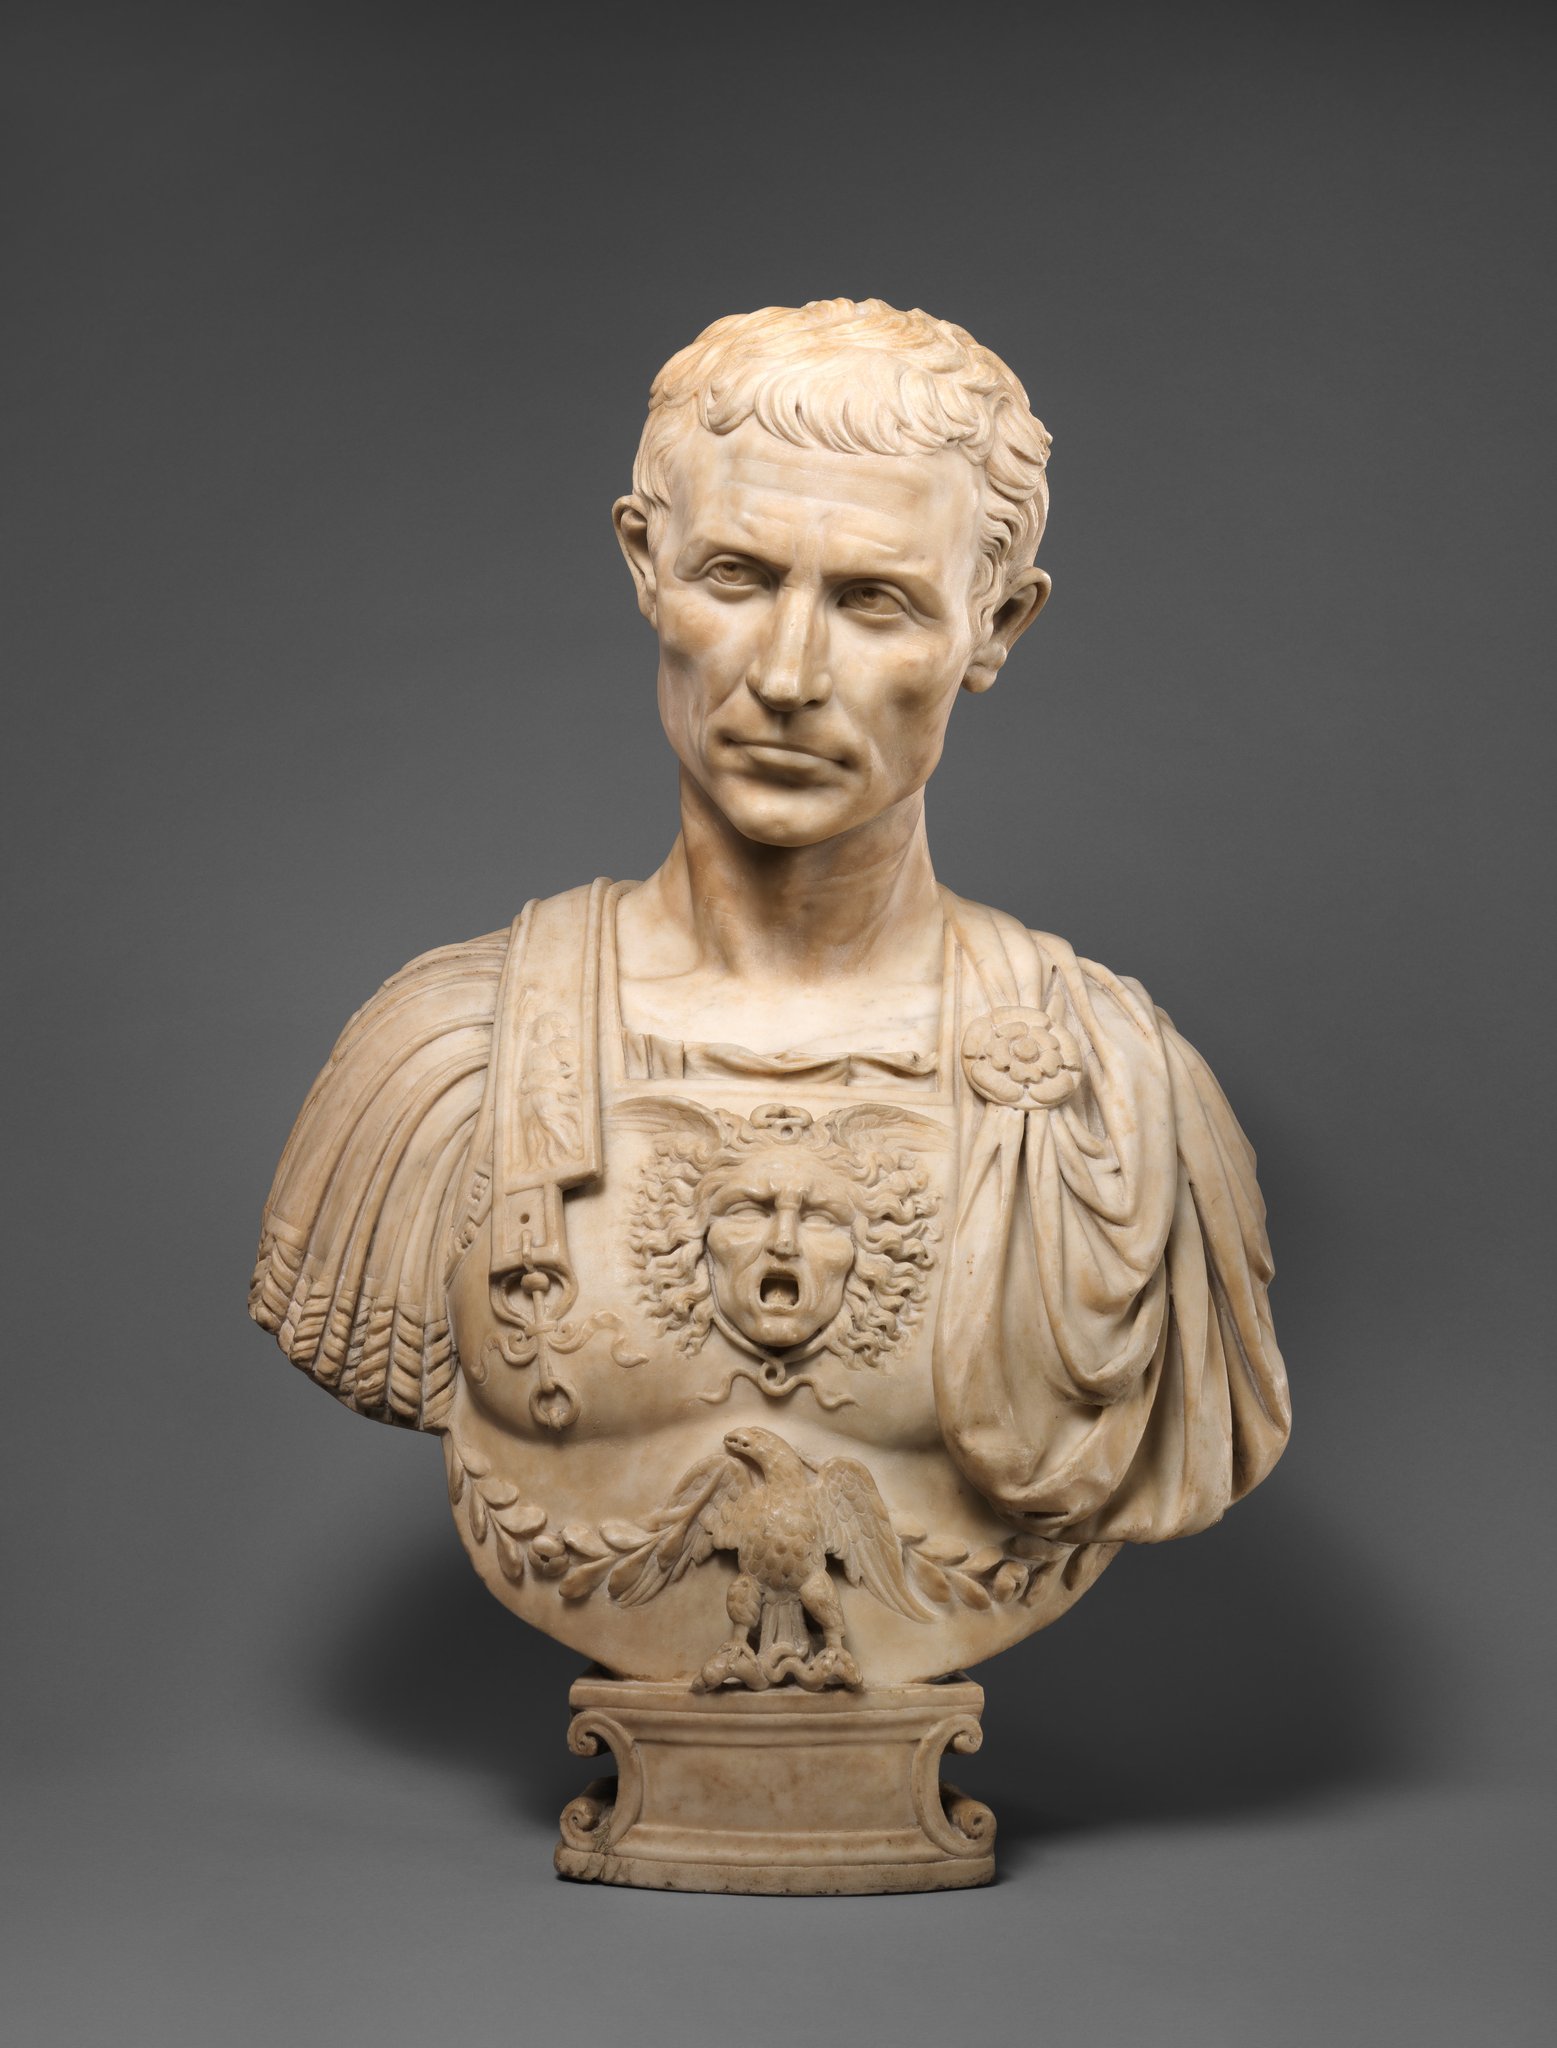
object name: bust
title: Julius Caesar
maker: andrea di pietro di marco ferrucci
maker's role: artist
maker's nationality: italian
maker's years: 1465-1526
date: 1512-1514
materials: marble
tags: eagles,julius caesar,faces,portraits